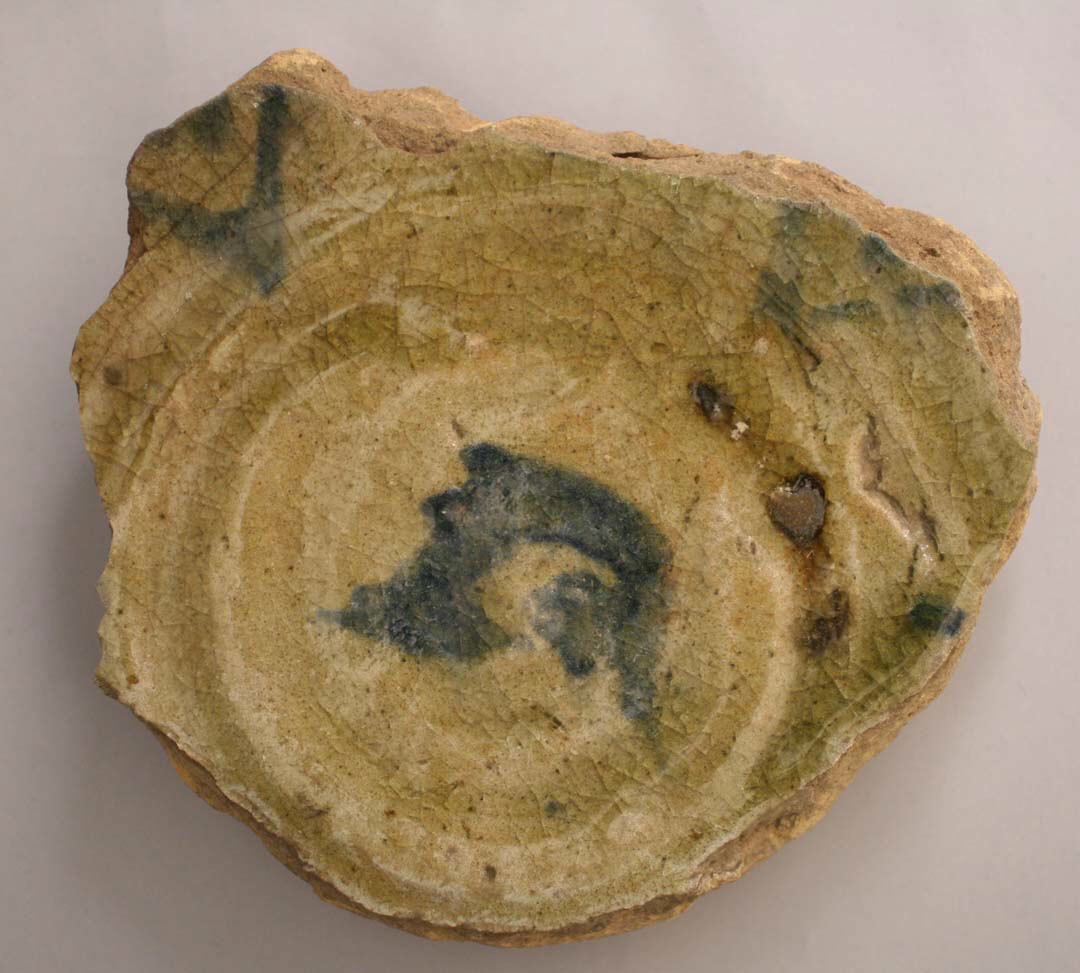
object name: ceramic fragment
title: Fragment of Dish with Fish Motif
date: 1401-1500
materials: glaze, stonepaste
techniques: painting, underglaze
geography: egypt